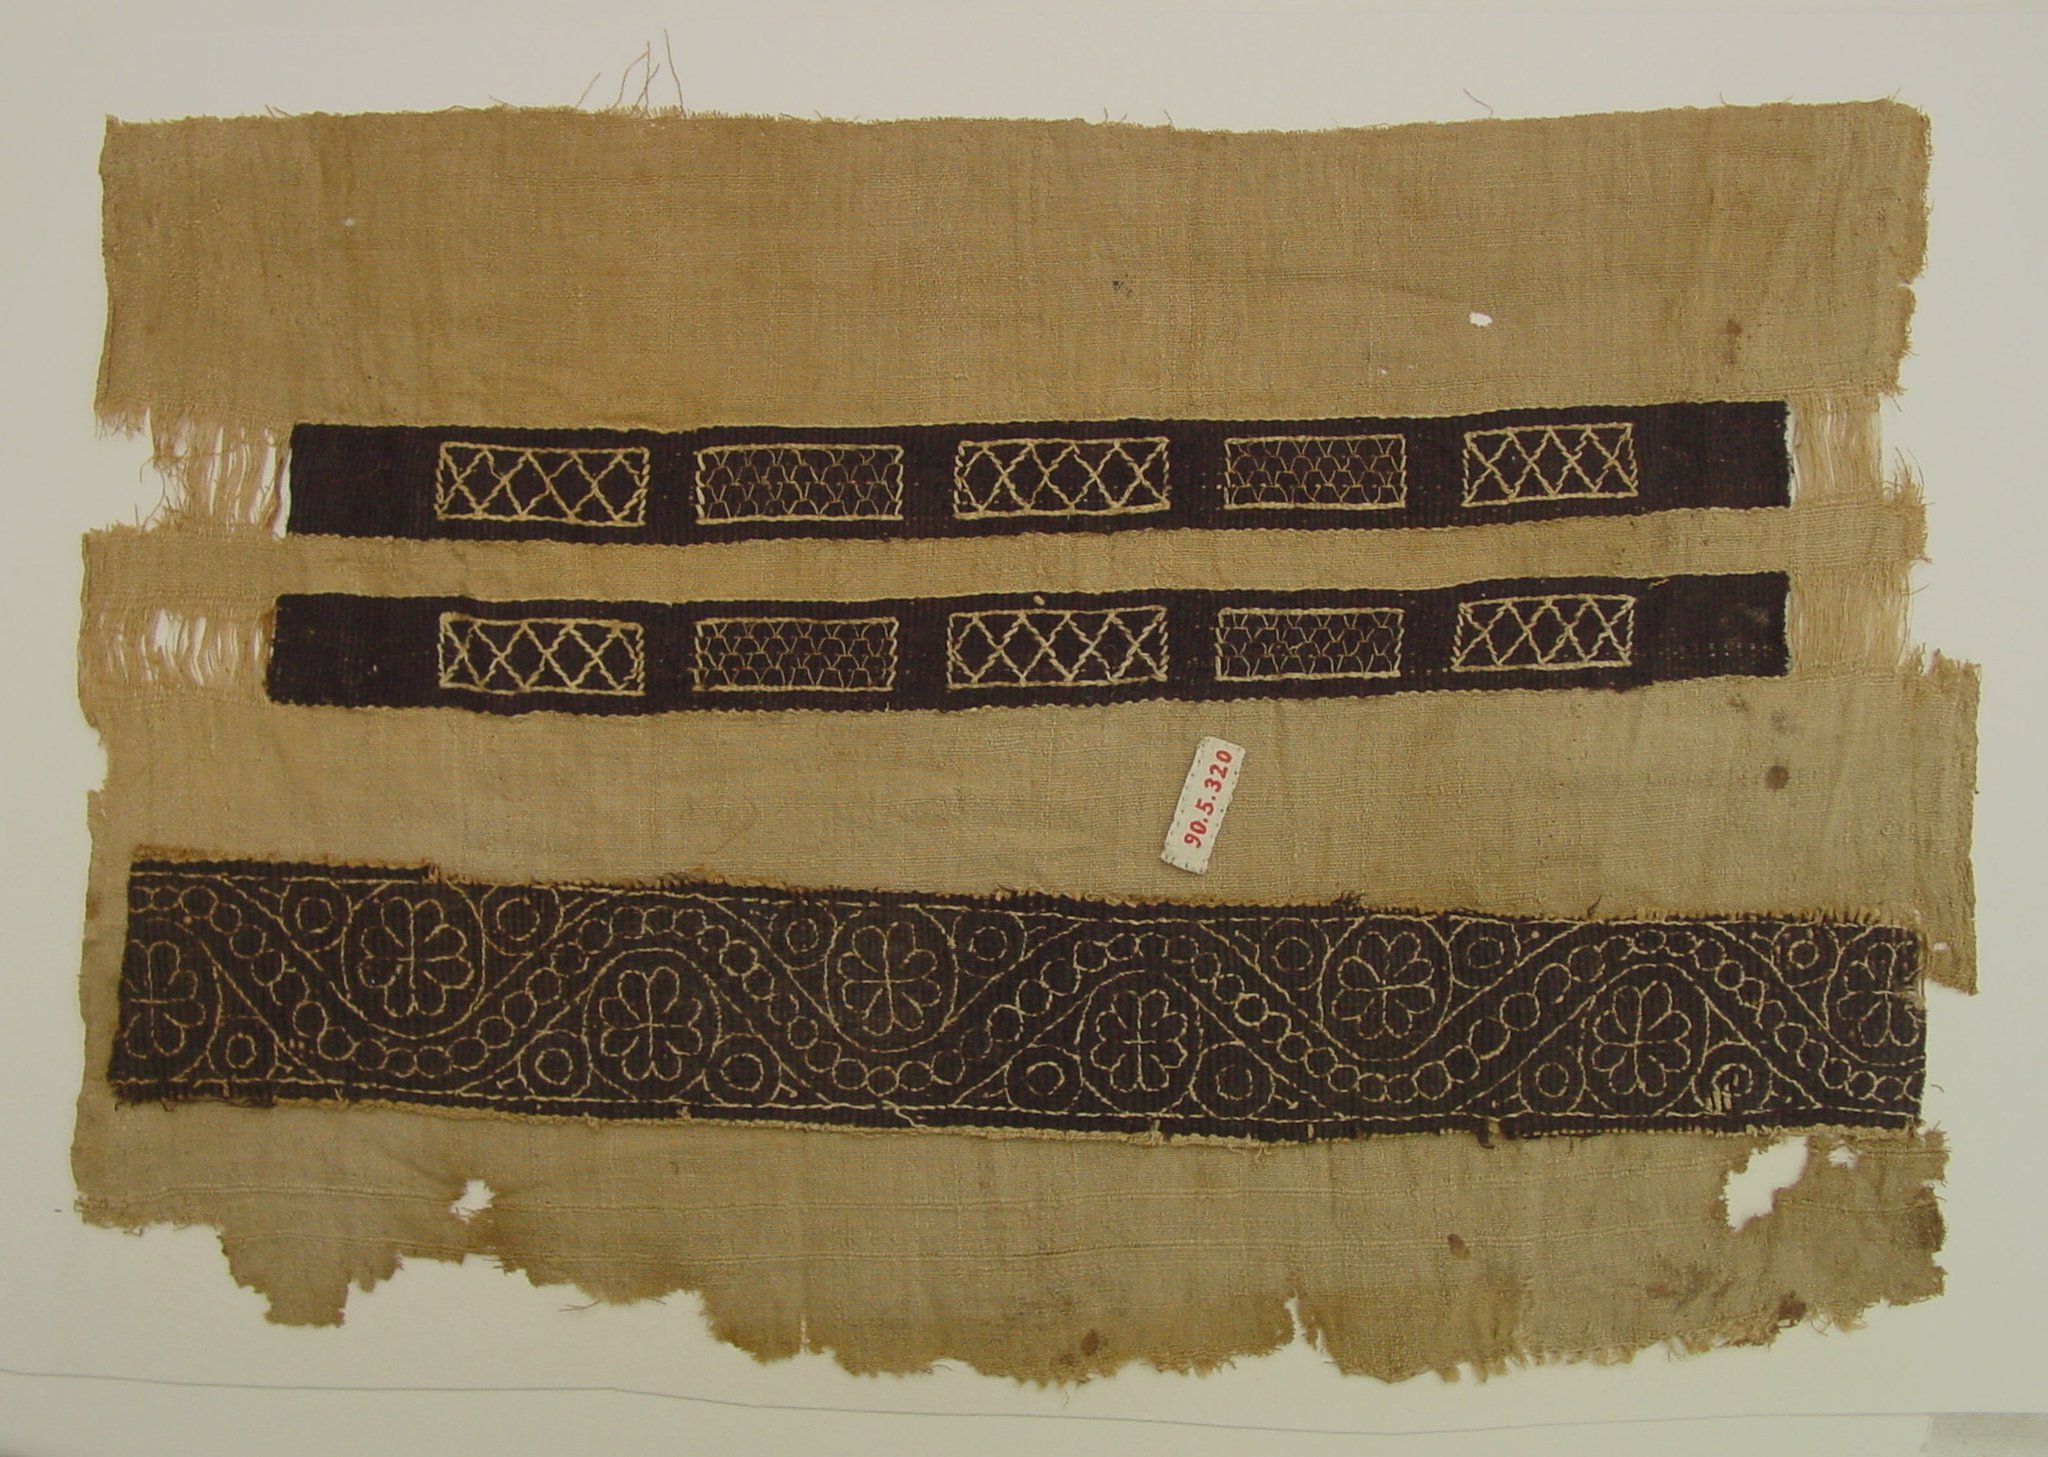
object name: textile fragment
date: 201-400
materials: linen, wool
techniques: weave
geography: egypt